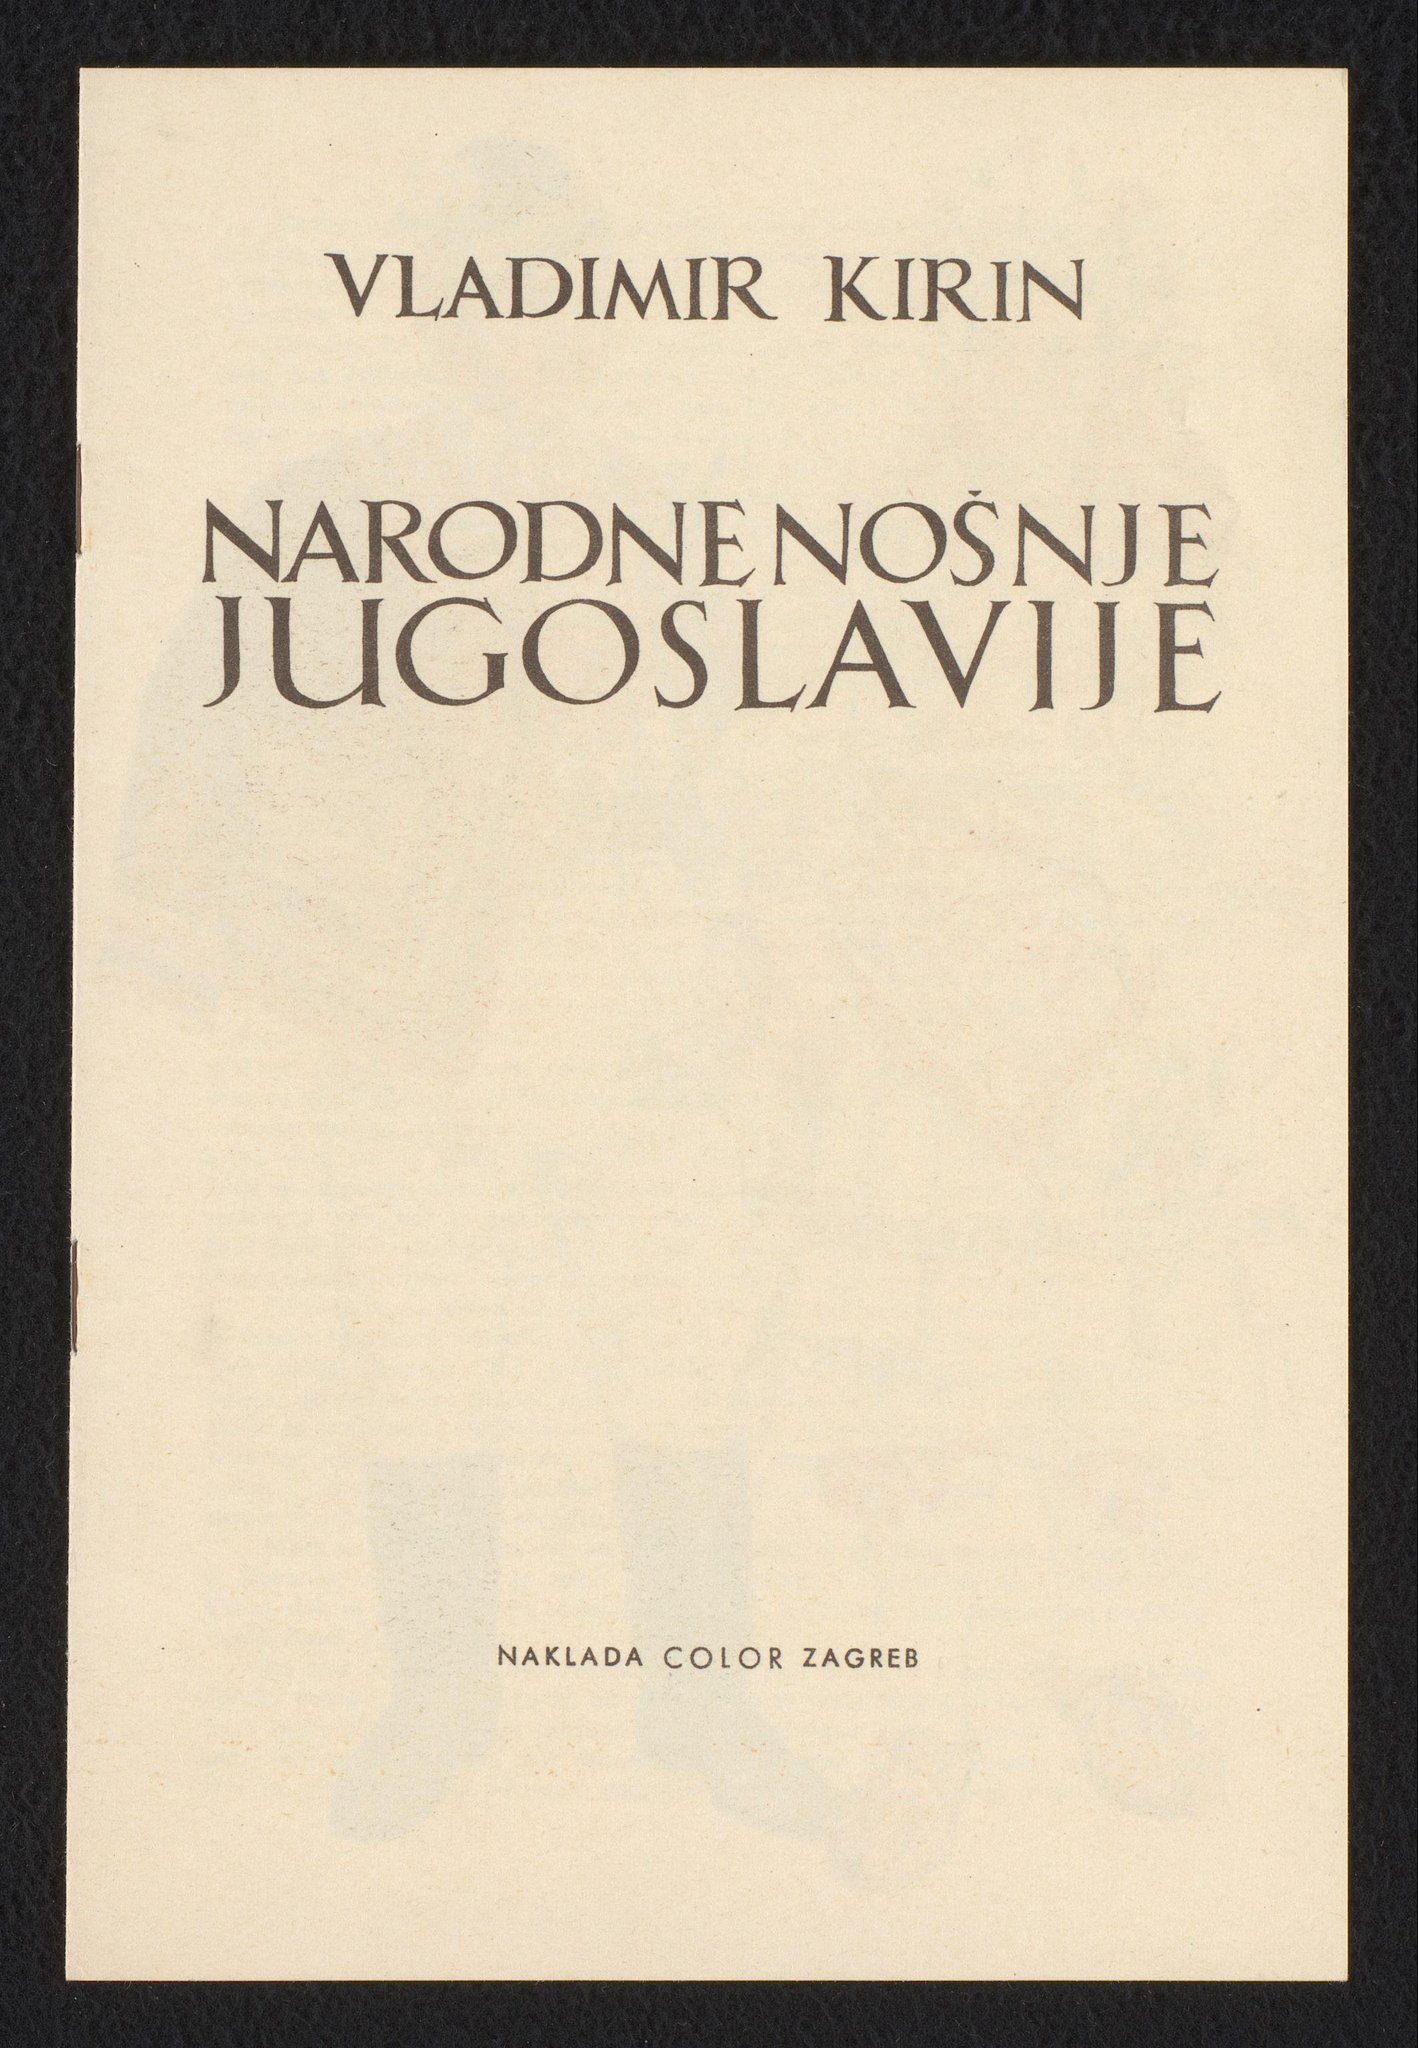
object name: prospectus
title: Prospectus voor: Vladimir Kirin, Narodne nošnje Jugoslavije, 1954-1955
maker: Anonymous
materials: paper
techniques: lithograph, letterpress printing, stapling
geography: zagreb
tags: folk costume, regional costume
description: Prospectus in de vorm van twee gevouwen bladen met op de voorzijde de titel. Binnenin beschrijvende tekst over de publicatie, in het Kroatisch en in het Duits, evenals drie voorbeeldafbeeldingen met figuren in traditionele Joegoslavische klederdracht.